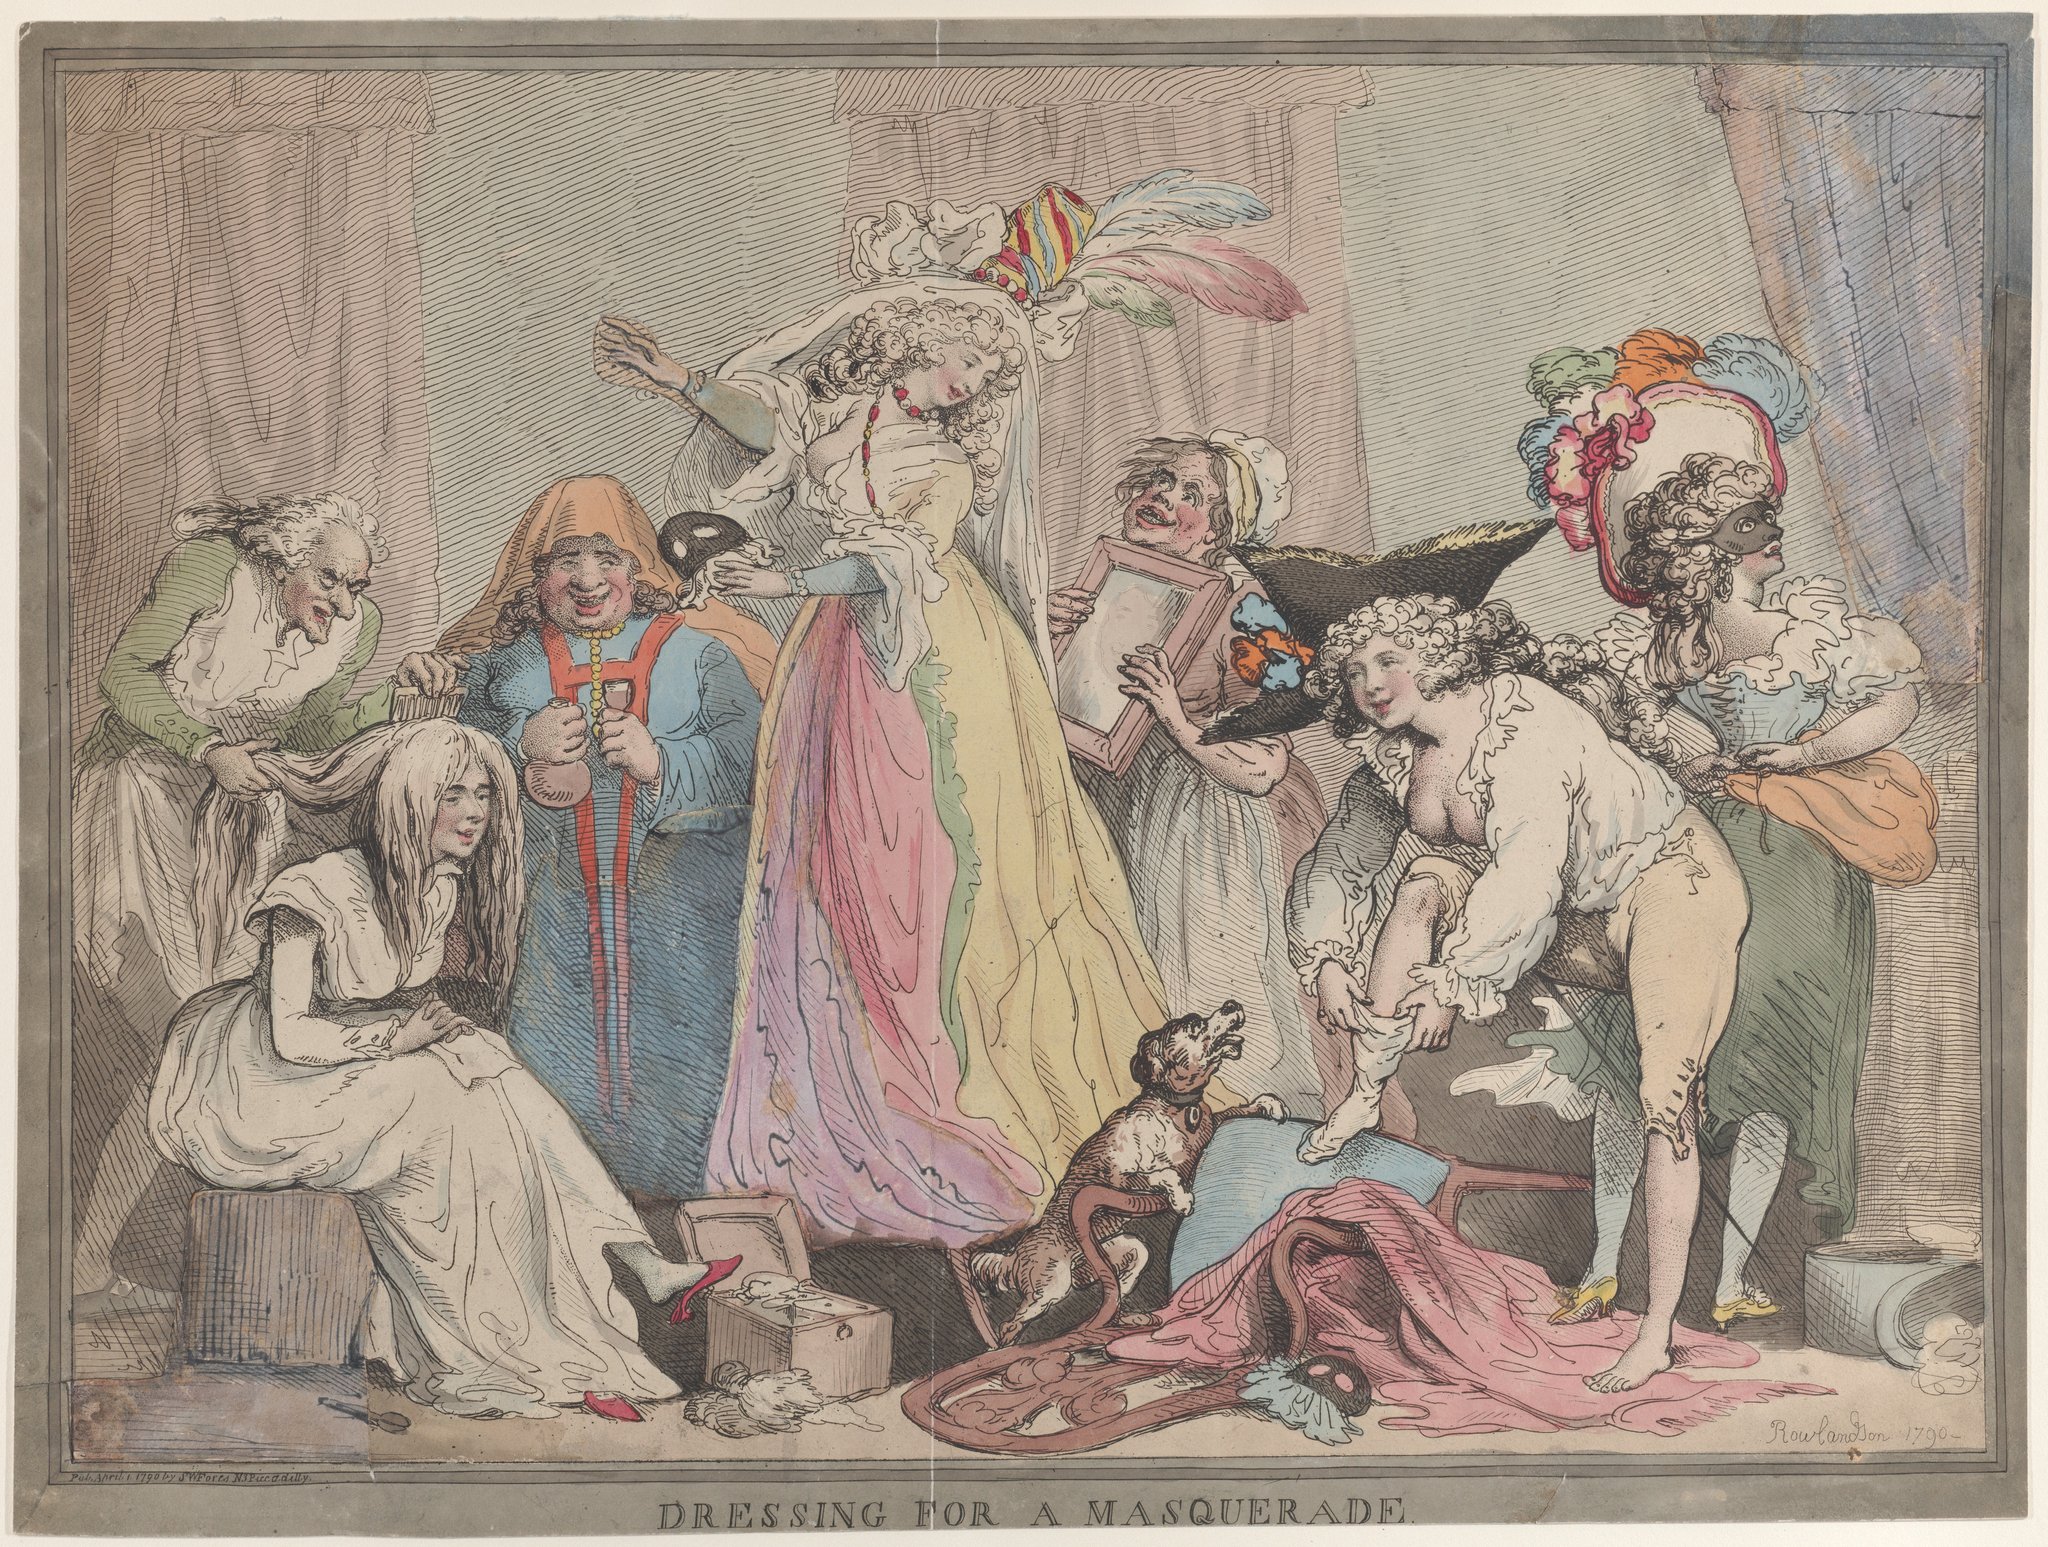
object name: print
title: Dressing for a Masquerade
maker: thomas rowlandson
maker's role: artist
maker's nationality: british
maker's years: 1757-1827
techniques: etching, stippling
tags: satire,men,women,dogs,dressing